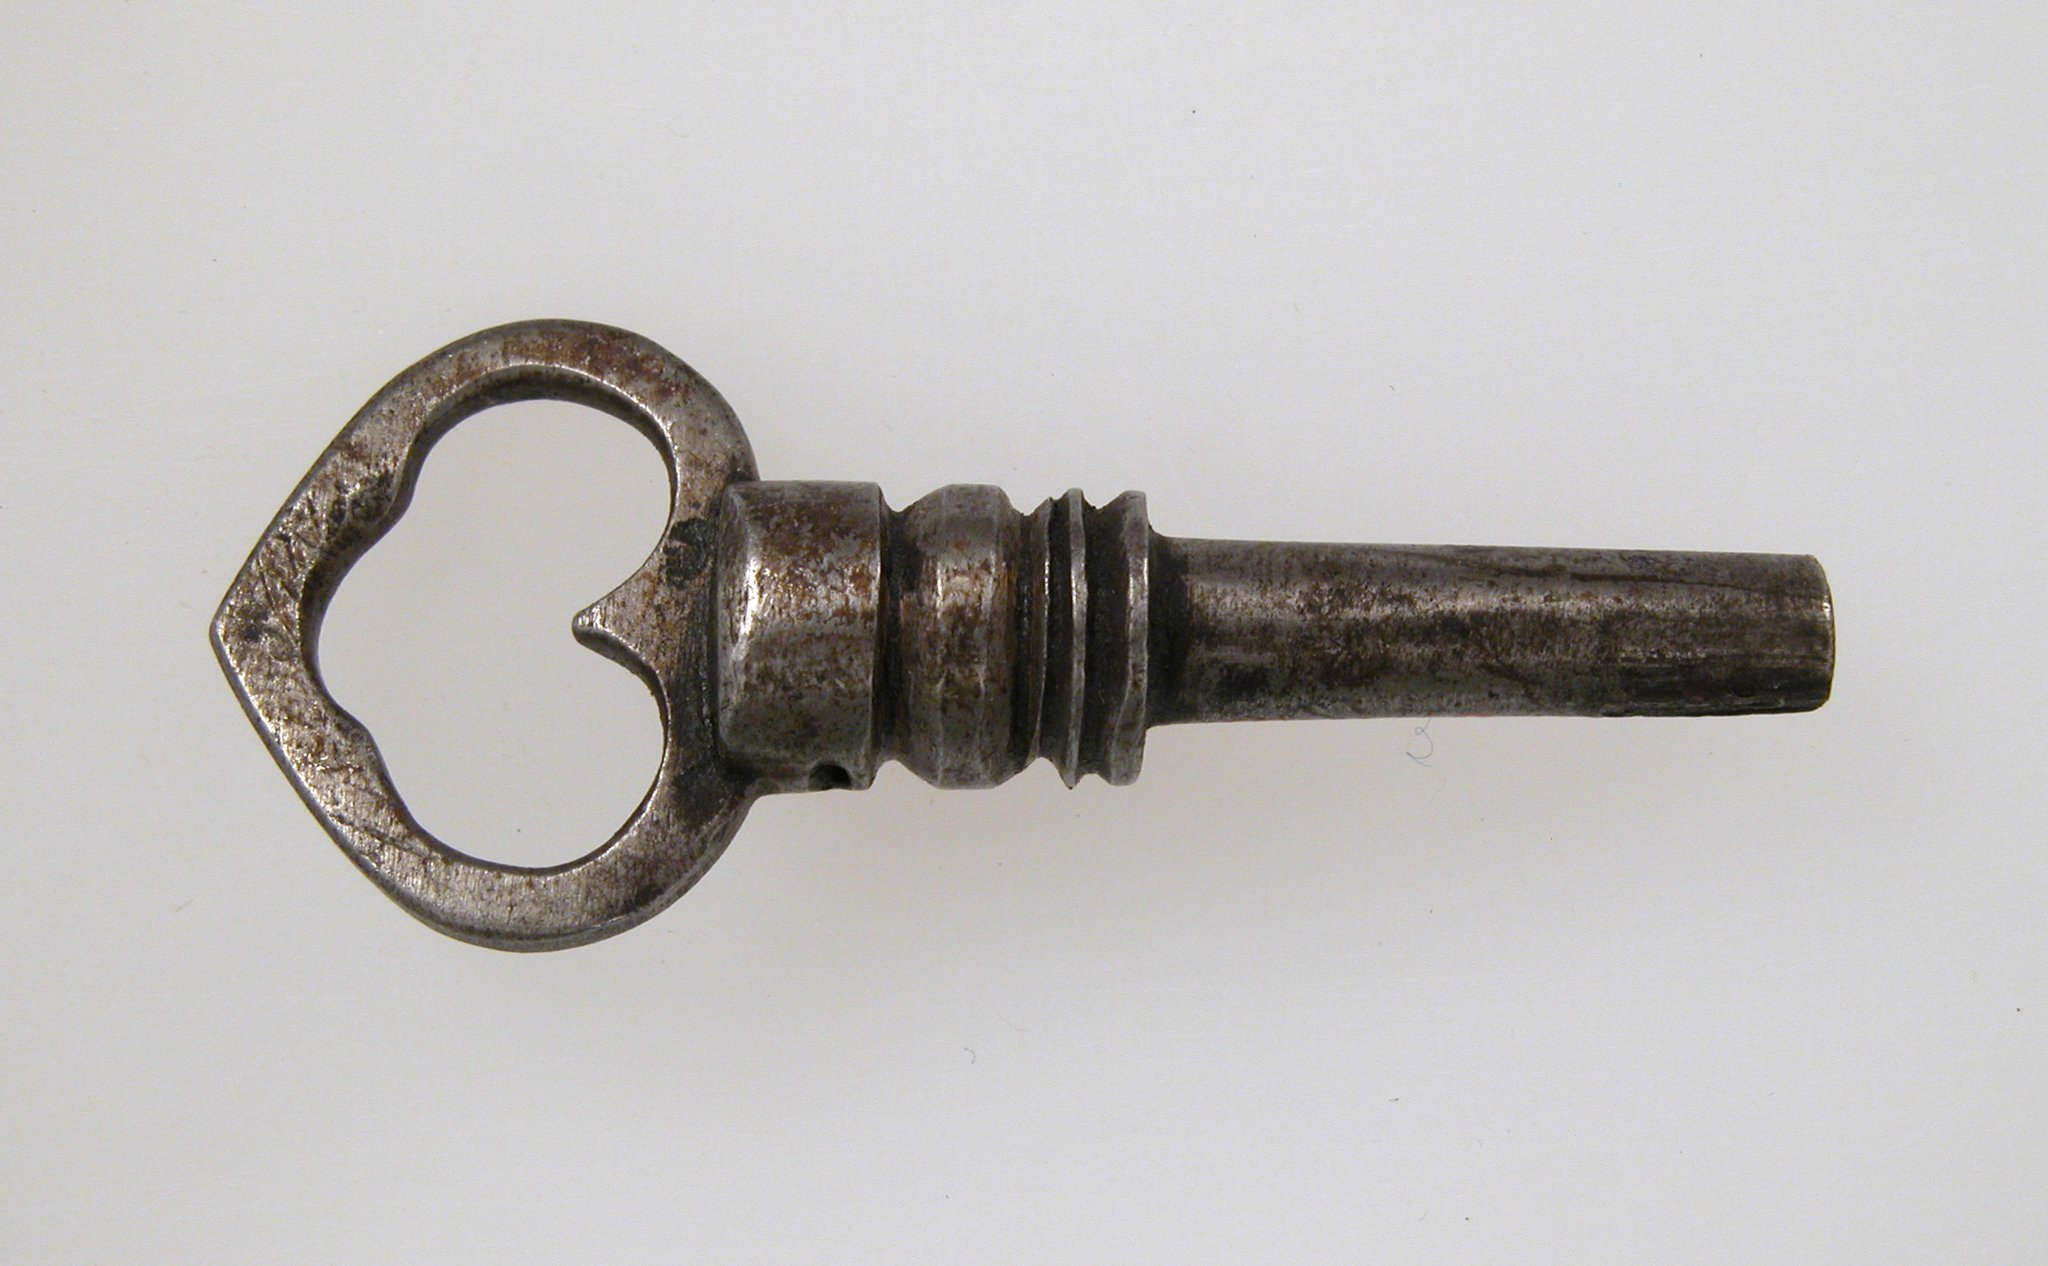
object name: key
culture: german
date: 1401-1500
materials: iron